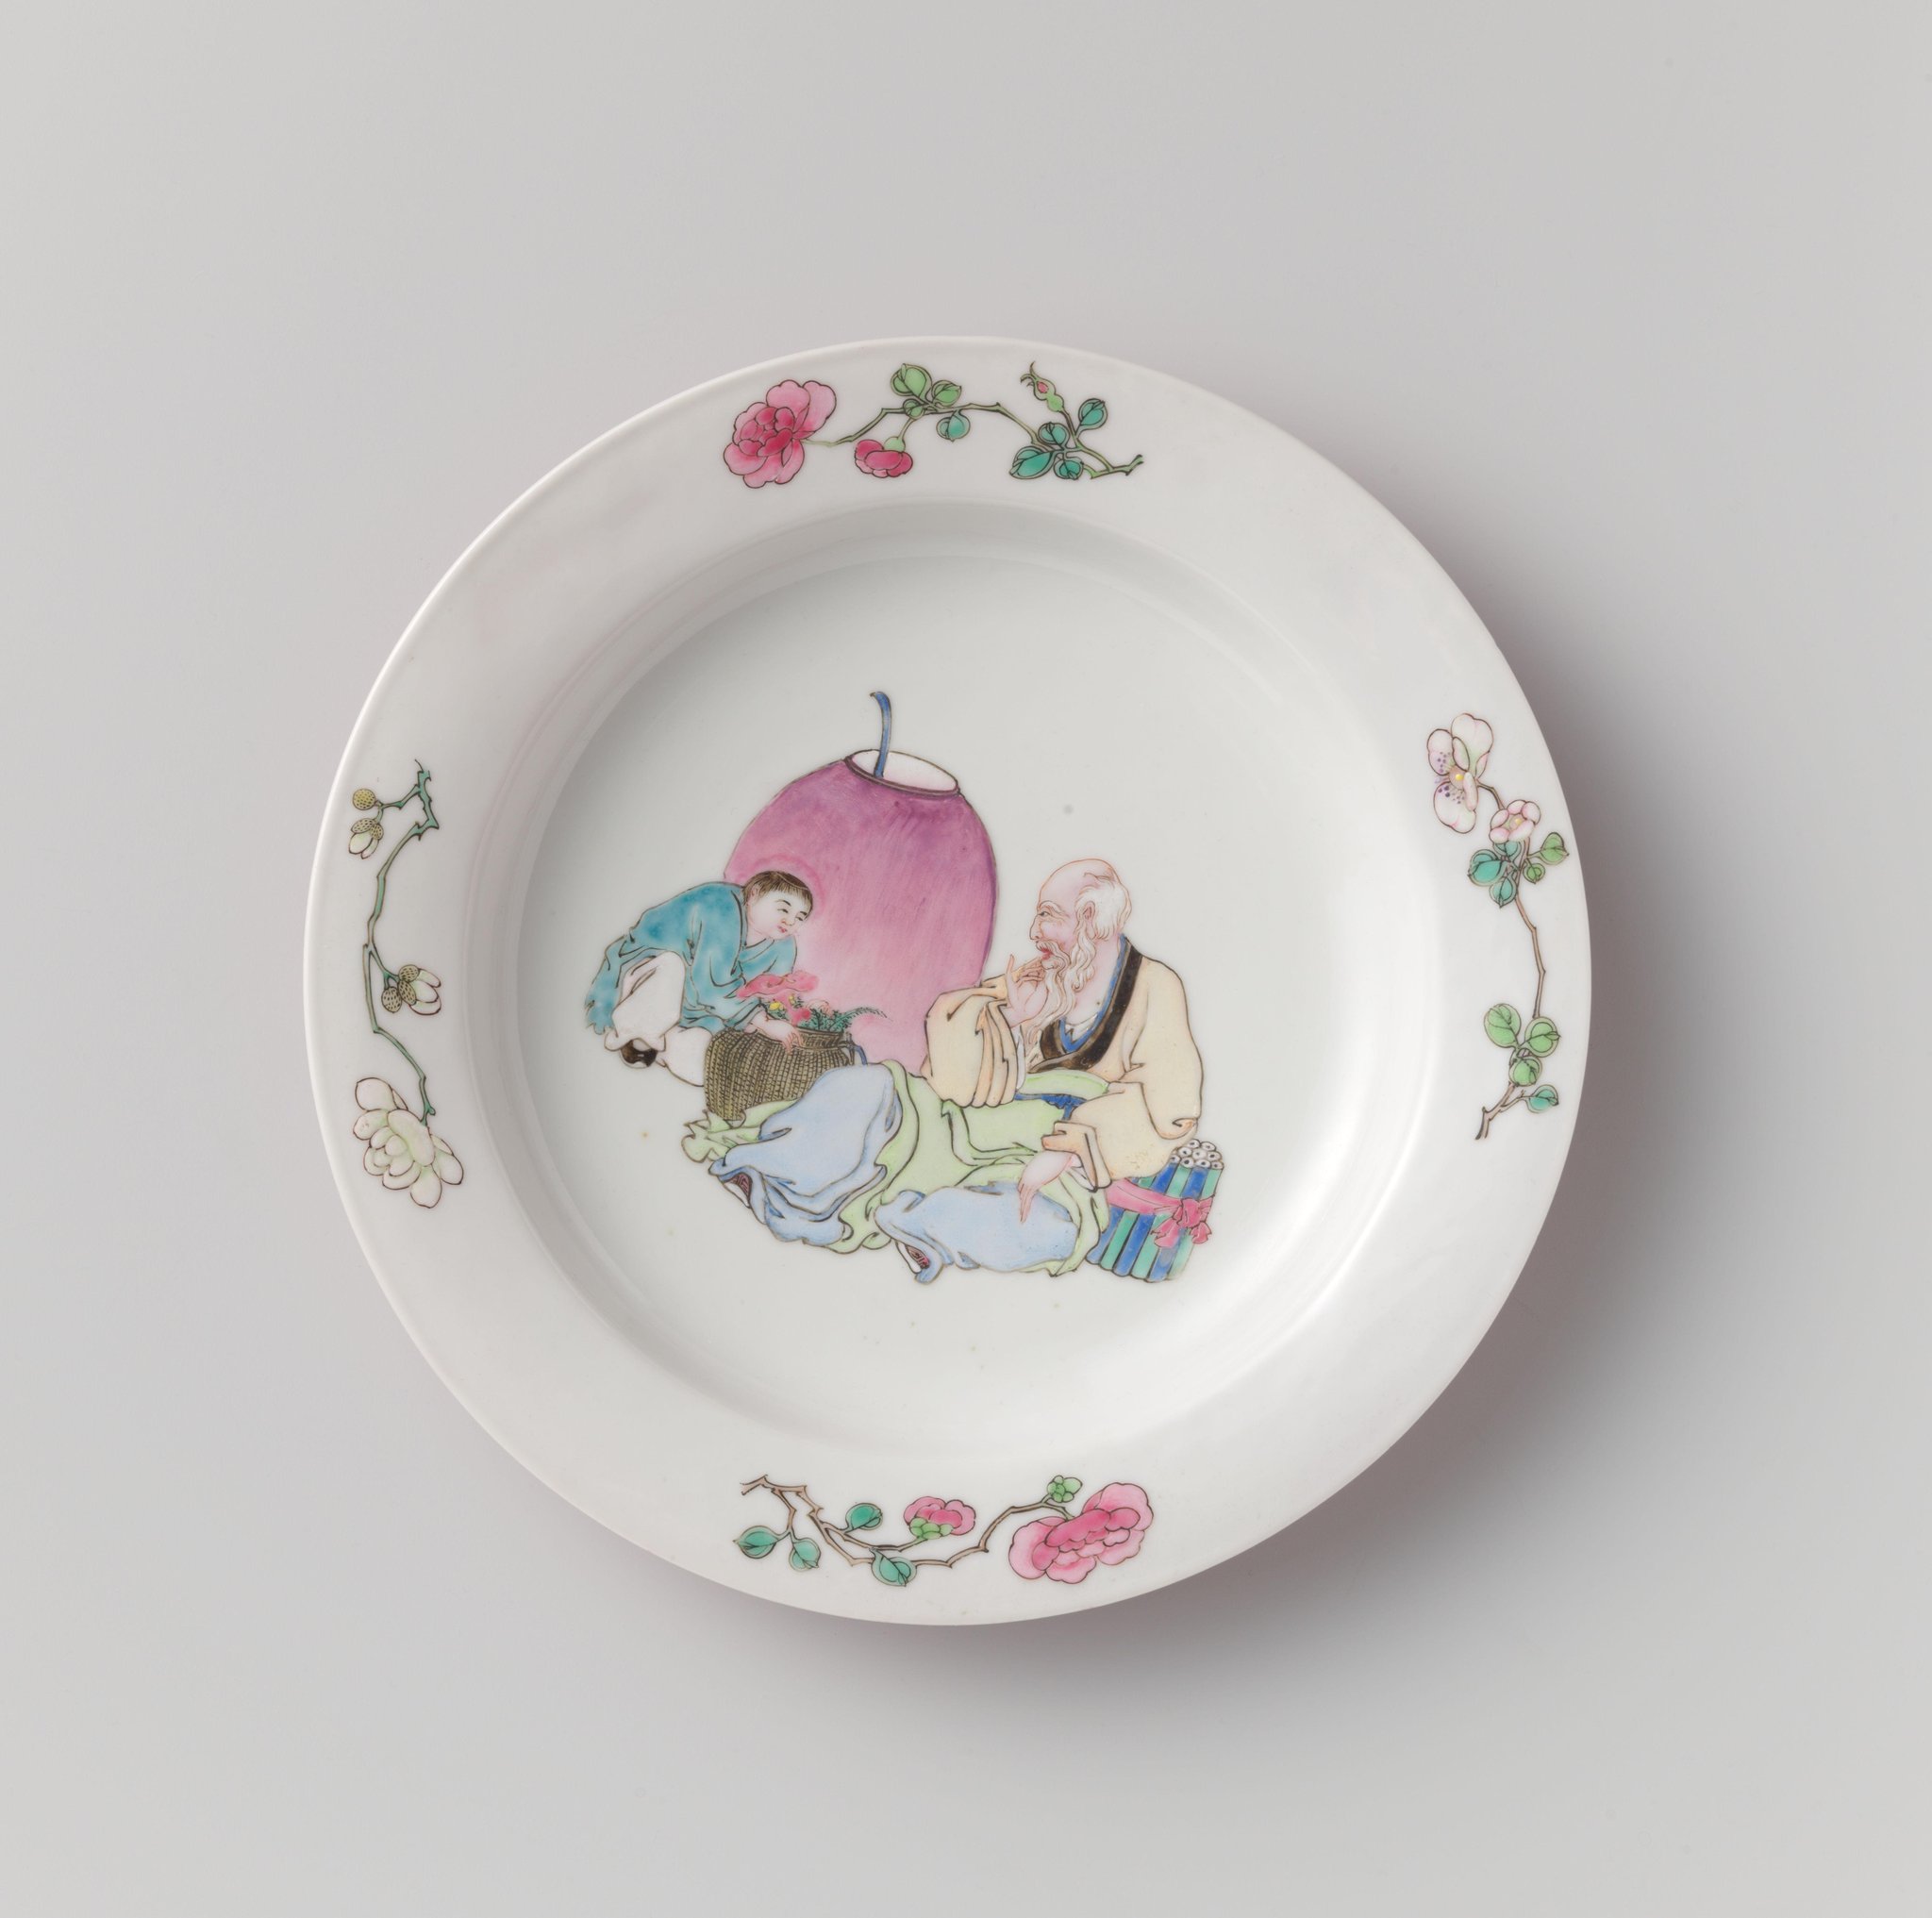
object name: plate dish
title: Plate with an old man and his attendant among perious objects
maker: Anonymous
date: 1725-1749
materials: glaze, gold, paint, porcelain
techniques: firing, gilding, turning, vitrification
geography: china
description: Bord van dun porselein, bedekt met een roze glazuur in beschilderd op het glazuur in blauw, rood, roze, groen, geel, zwart en goud. Op het plat een gezeten oude man tussen gelukssymbolen, naast hem een bediende met een bloemenmand; de rand met vier bloemtakken. De achterzijde is bedekt met een roze glazuur. Famille rose met een ruby back.